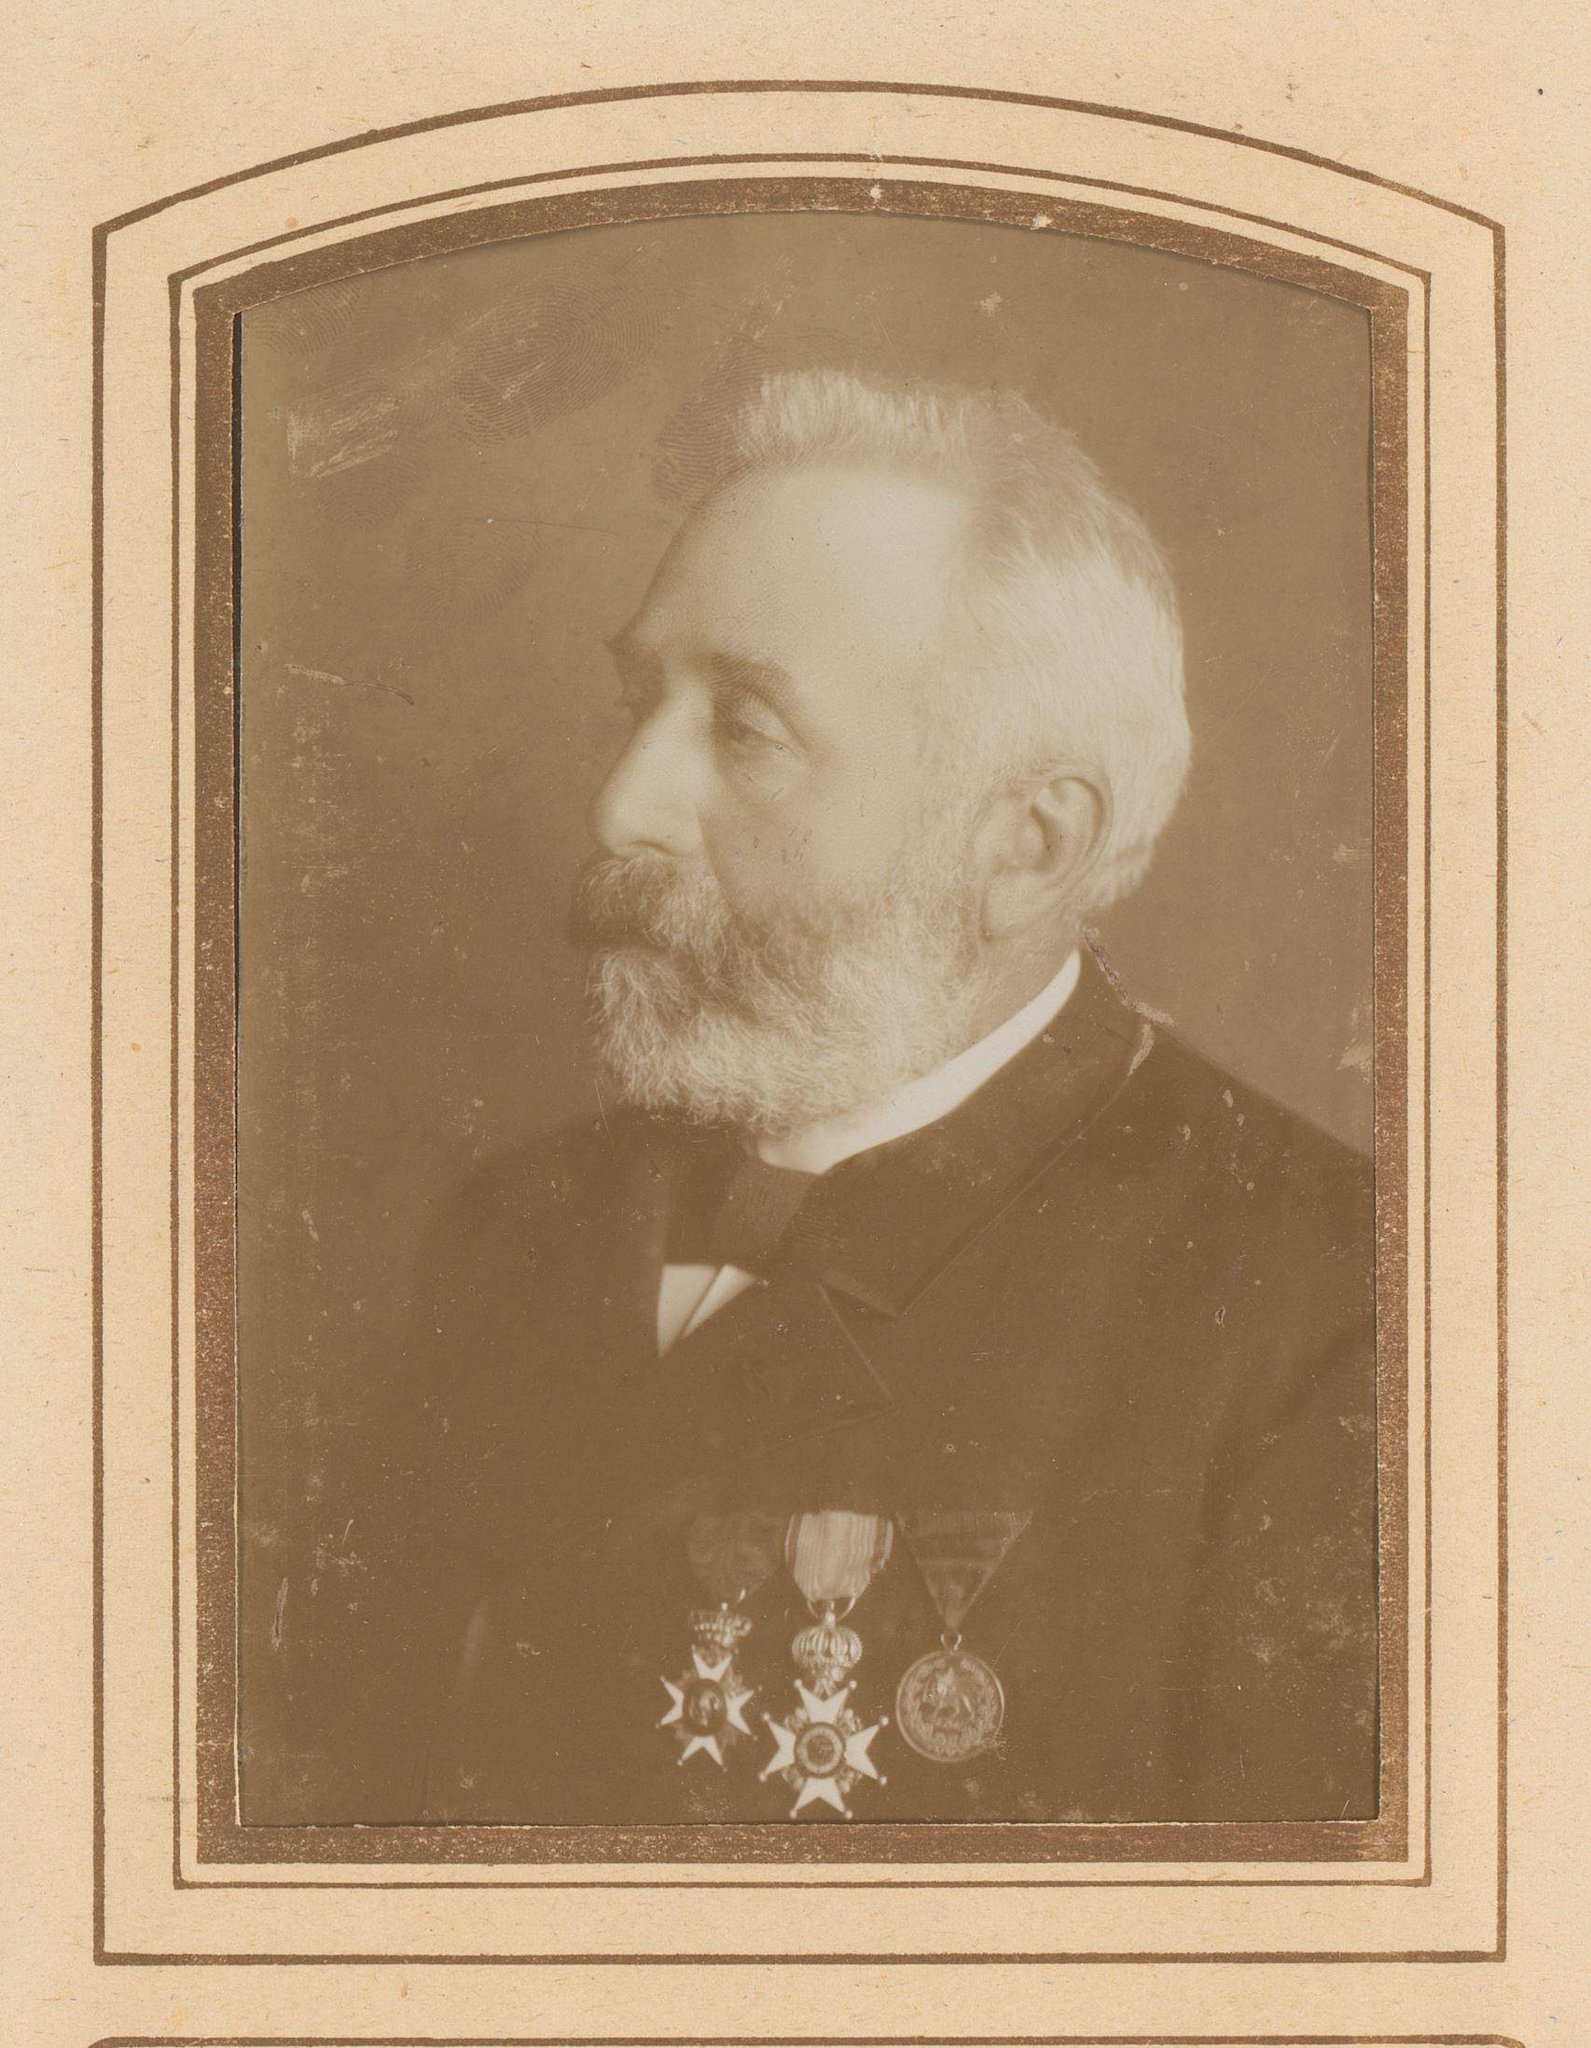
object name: album leaf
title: Portret van een man met baard en drie medailles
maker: Anonymous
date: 1880-1920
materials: cardboard, photographic support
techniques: collodion silver print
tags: historical persons, medals and other marks of military honour, beard